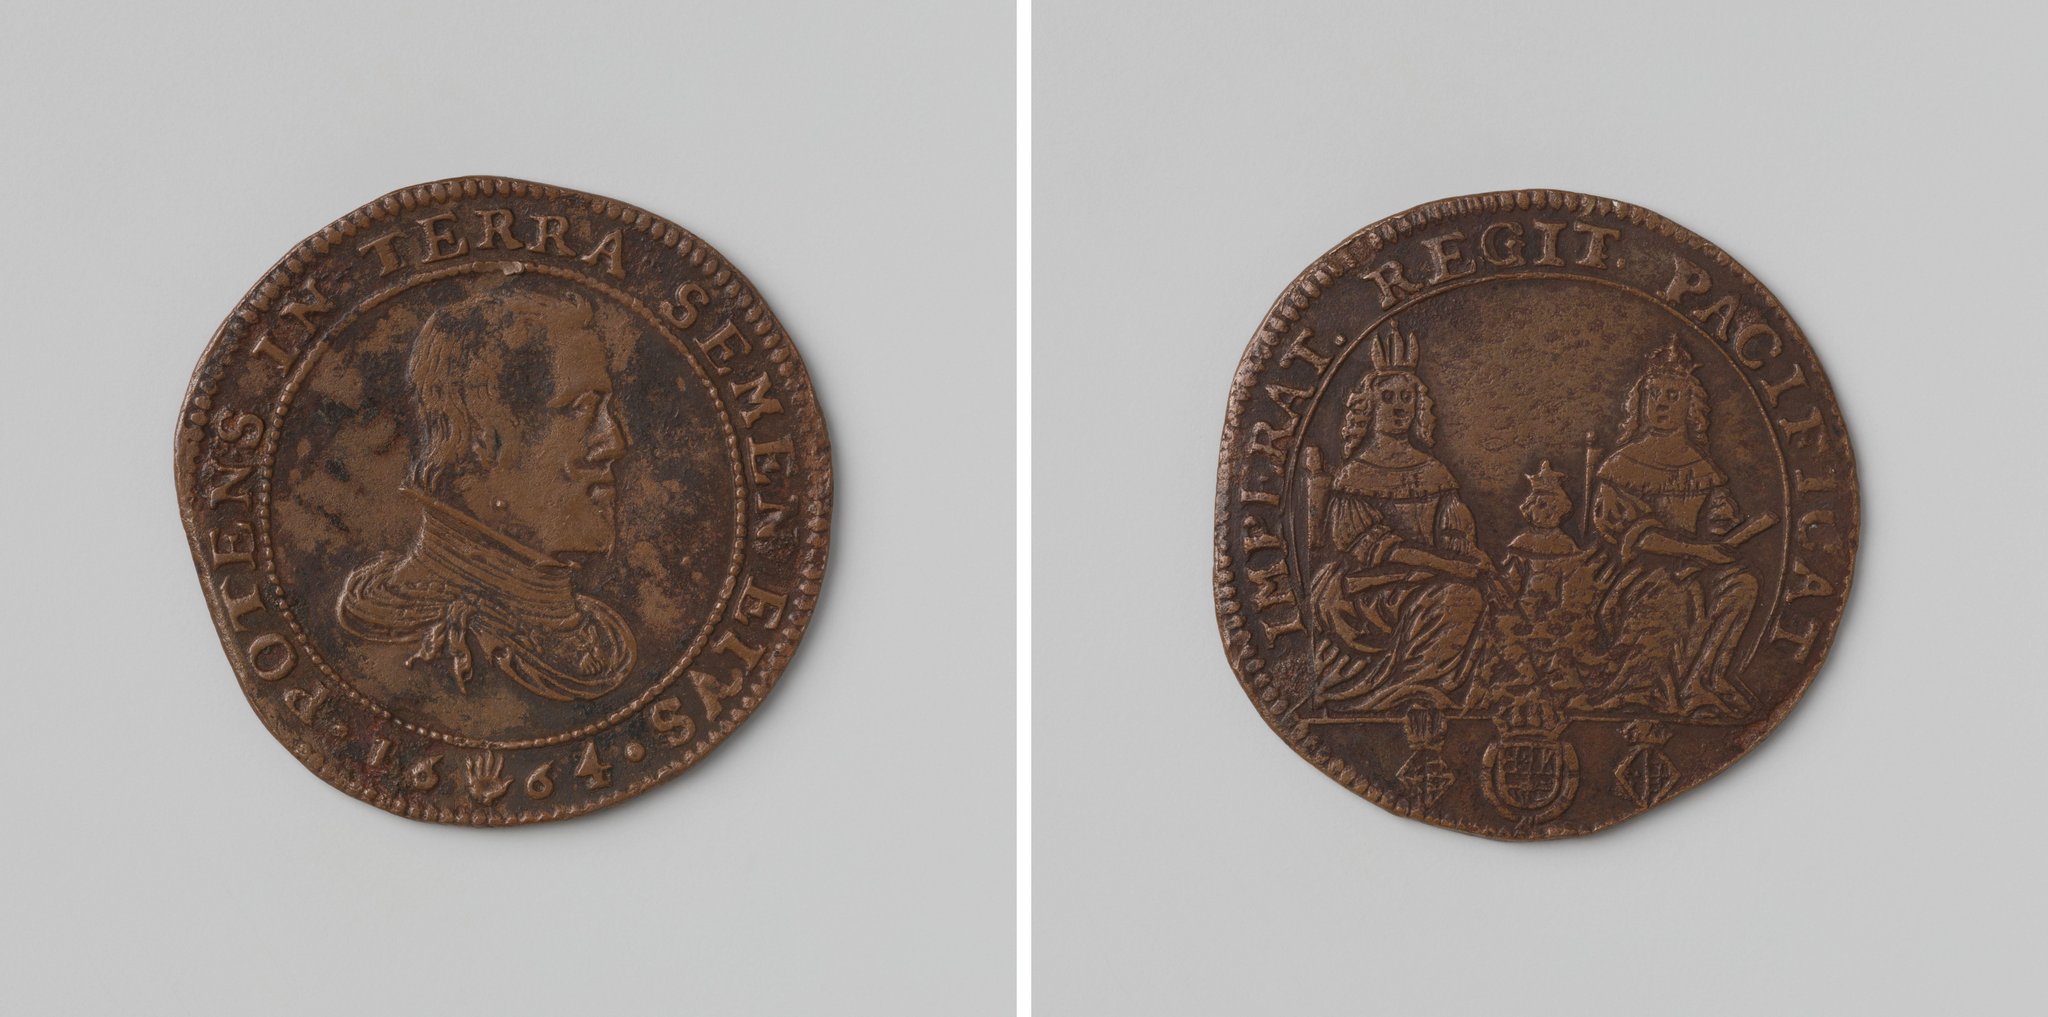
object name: jeton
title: Filips IV, koning van Spanje, vader van de koningin van Frankrijk, de Duitse keizerin en de erfprins van Spanje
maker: Anonymous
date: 1664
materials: copper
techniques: striking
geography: antwerp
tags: filips iv (koning van spanje), maria theresia (koningin van frankrijk), karel ii (koning van spanje)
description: Koperen penning. Voorzijde: borststuk man binnen omschrift. Keerzijde: drie kinderen van Filips IV binnen omschrift; afsnede: drie gekroonde wapenschilden